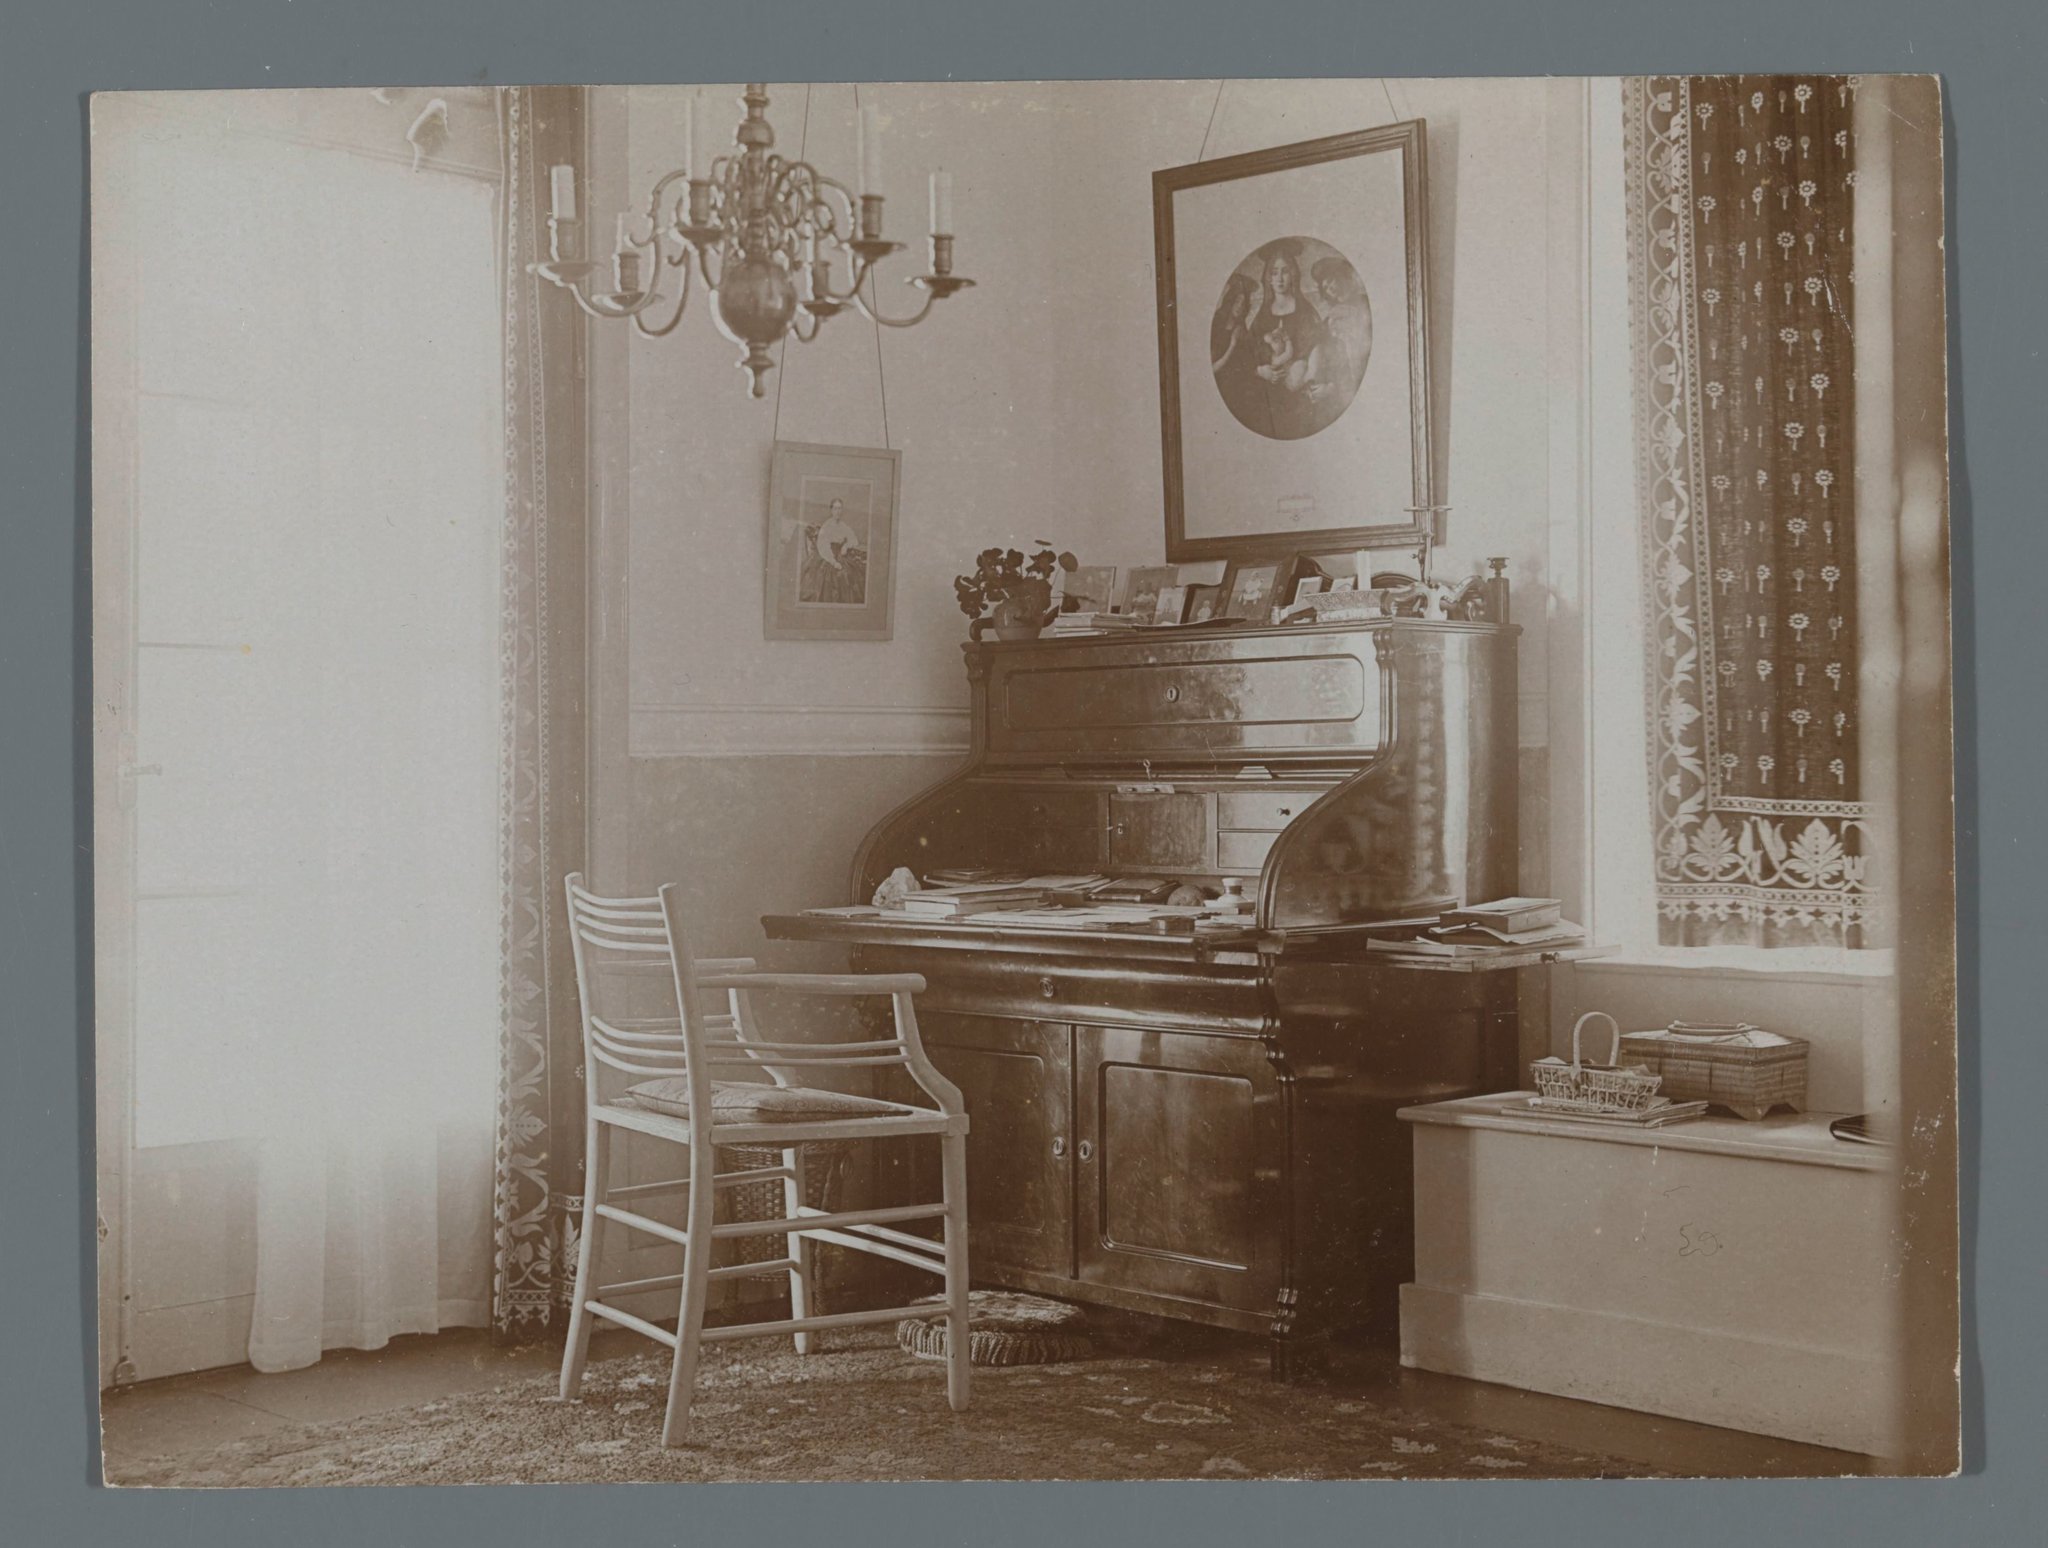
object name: photograph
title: Interieur met een bureau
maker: cornelia hendrika jonker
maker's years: 1874-1924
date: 1880-1940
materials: photographic support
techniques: collodion silver print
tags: writing-table, writing-desk, interior of the house